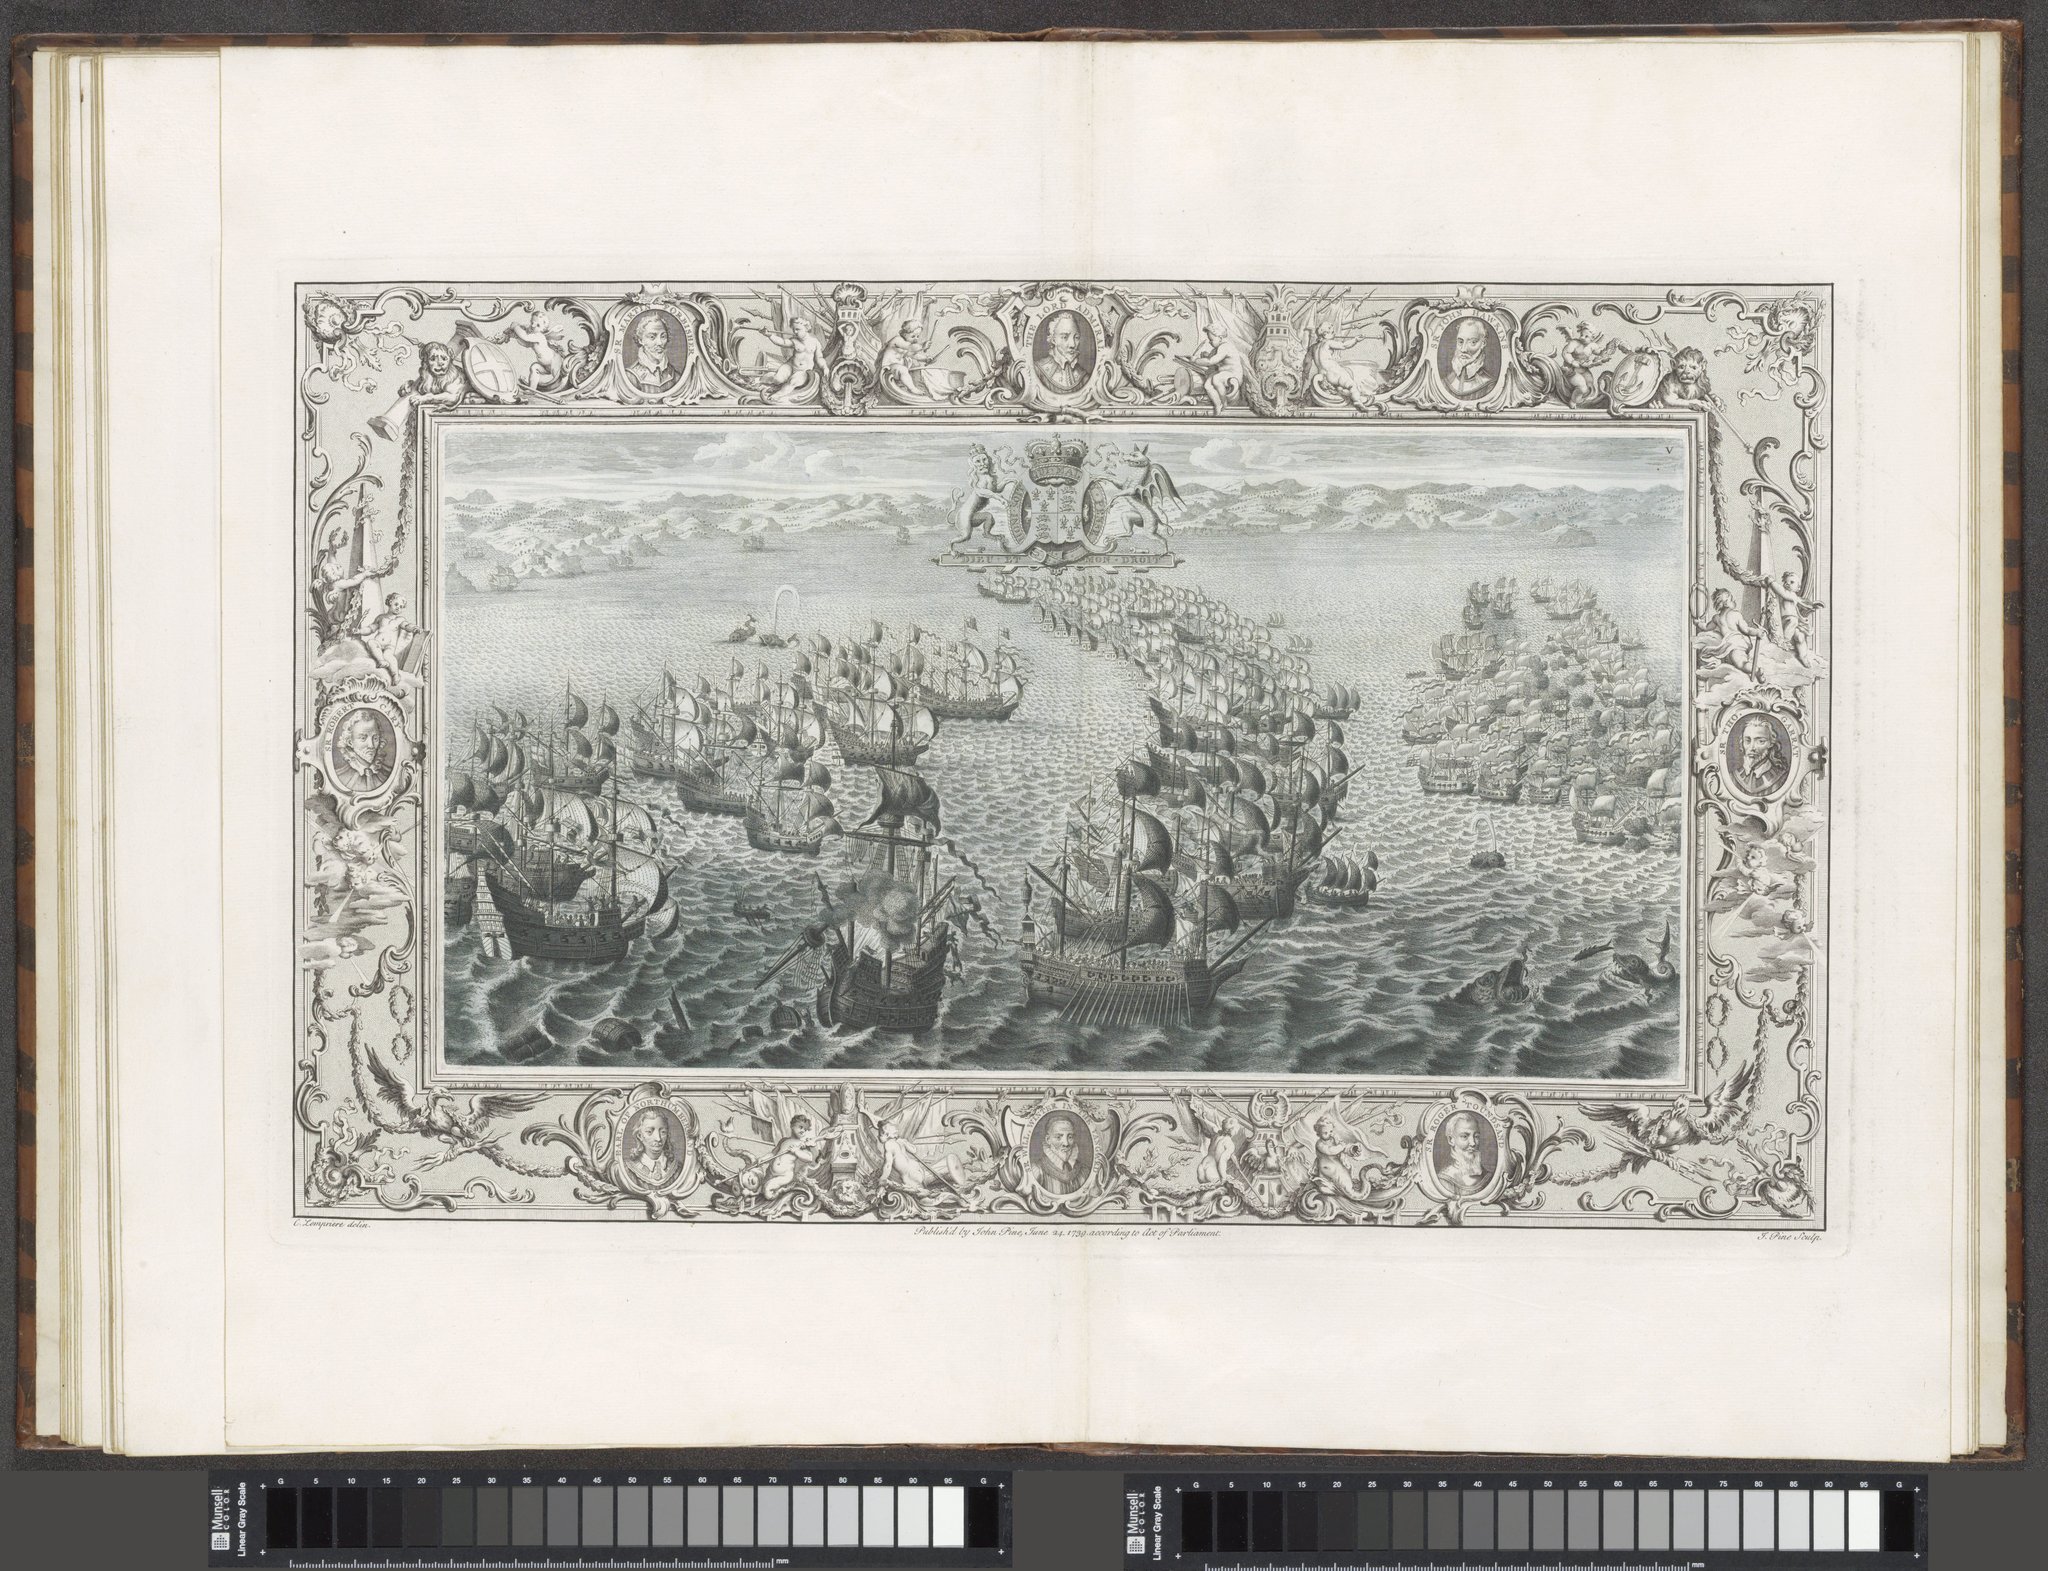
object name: book illustration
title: Reproductie van een wandtapijt over de Spaanse Armada (22-23 juli)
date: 1739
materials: paper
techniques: engraving, etching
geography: london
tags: plymouth, coat of arms (as symbol of the state, etc.), obelisk, needle, wind as a human face, blowing with rounded cheeks, battle (+ naval force), parts of ship's exterior: bow, tapestry, cupids: 'amores', 'amoretti', 'putti', armorial bearing, heraldry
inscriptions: date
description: Engelse en Spaanse vloot in Het Kanaal in de buurt van de Isle of Portland en Weymouth, met bovenaan het wapen van de Engelse koningin Elizabeth I. Op de voorgrond breekt een mast van een van de schepen af. De voorstelling (genummerd V) is gevat in een ornamentrand met acht portretten van bevelhebbers van de Engelse vloot. Midden boven het portret van Charles Howard, Lord High Admiral en opperbevelhebber van de Engelse vloot tegen de Spaanse Armada. Boven en onder tussen de portretten scheepsboegen met speren en vaandels en geflankeerd door putti. Zij blazen op een bazuin of schelp, trommelen, schrijven etc. Links en rechts staan vier putti bij een triomf- of gedenkzuil. Twee putti versieren de zuil met guirlandes. Een derde putti schrijft de gebeurtenissen op een in boek; de vierde heeft een zwaard en ouroboros in de hand. De ouroboros is een slang die in zijn eigen staart bijt en is daarmee een symbool van de eeuwigheid. Verder twee adelaars met bliksemschichten, de vier winden en twee leeuwen met zuil of drietand en een wapenschild. De rechter toont het Anker van Hoop, het wapen van de Engelse Admiraliteit. De voorstelling maakt deel uit van een boek over de Spaanse Armada en de tapijten die daarover in opdracht van Charles Howard werden gemaakt.